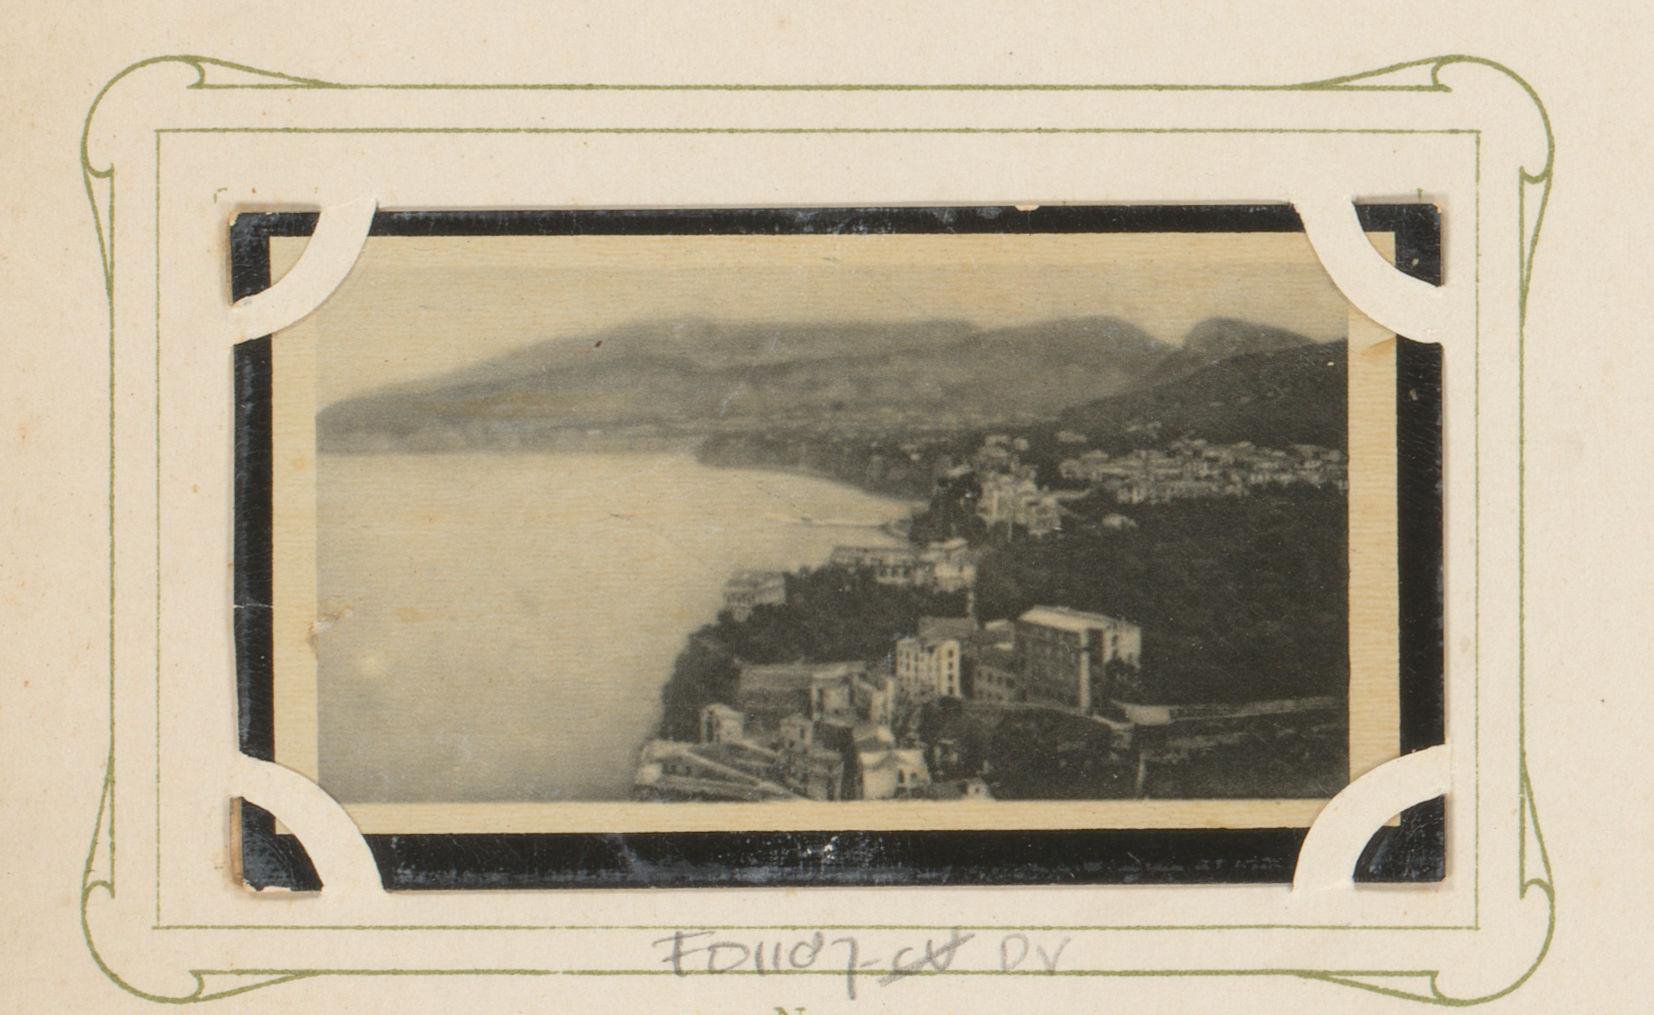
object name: album leaf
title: Gezicht op Sorrento, Italië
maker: Anonymous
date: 1905-1906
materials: paper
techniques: photograph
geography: sorrento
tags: prospect of city, town panorama, silhouette of city, sorrento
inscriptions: inscription: ‘No. 3./ Sorrento.’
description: Deze prent maakt deel uit van een album.